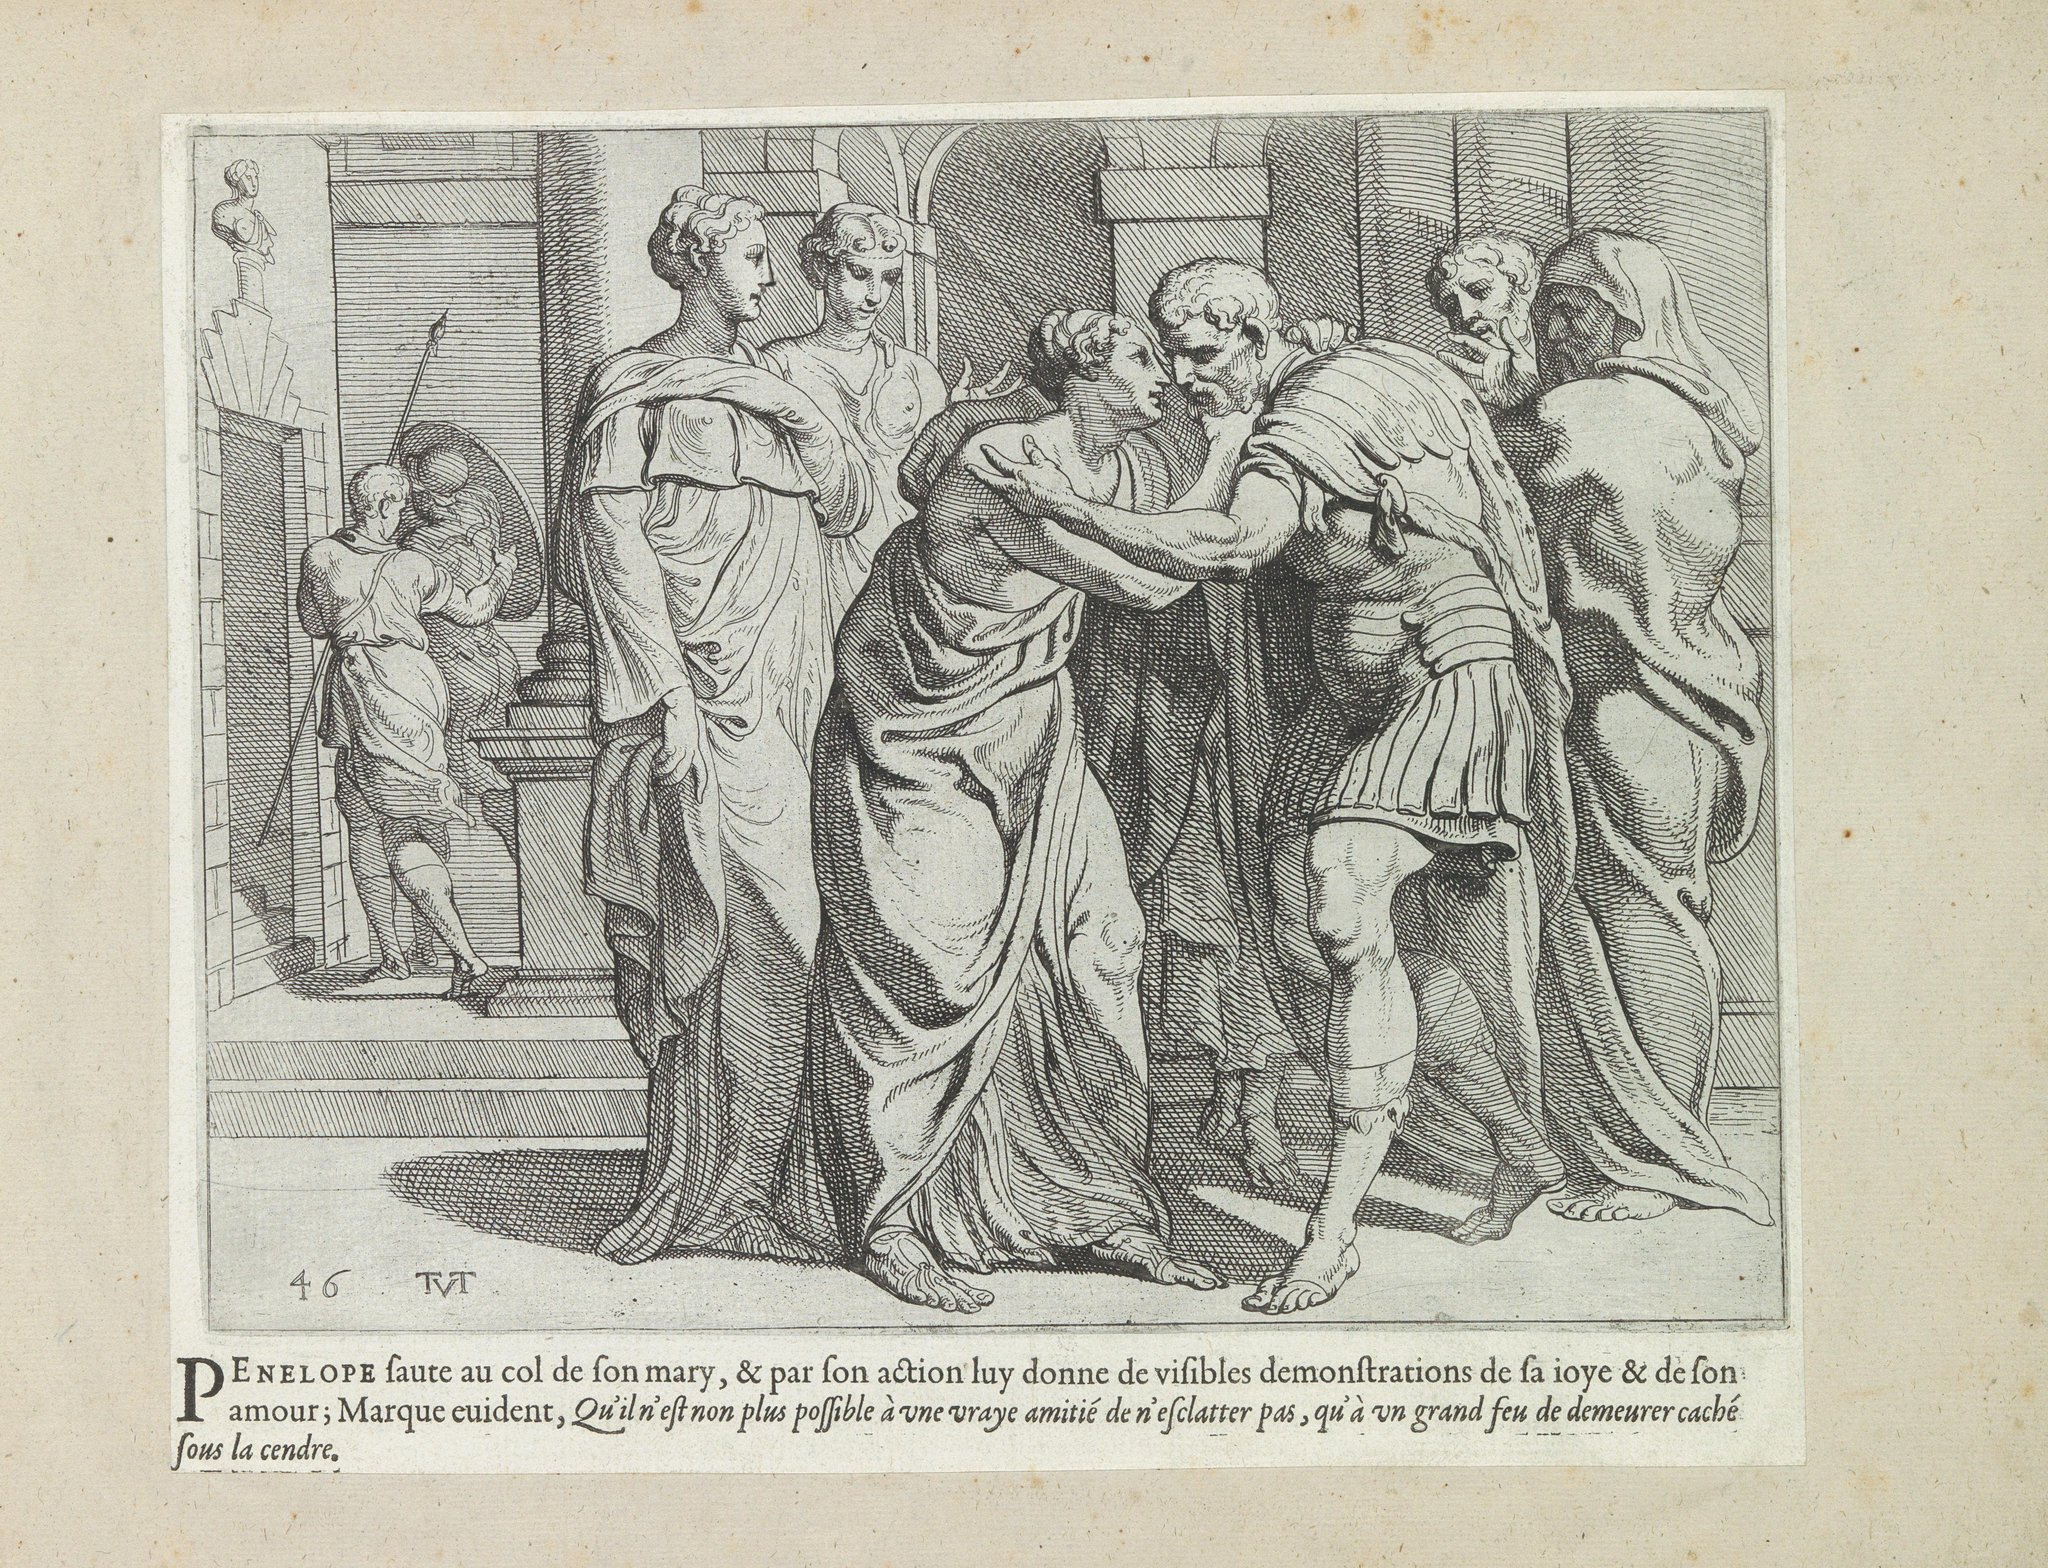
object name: print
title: Les Travaux d'Ulysse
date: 1633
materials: paper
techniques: engraving, etching, letterpress printing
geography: paris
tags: penelope and ulysses embrace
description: Na de lange omzwervingen van Odysseus vallen hij en Penelope elkaar in de armen. De prent maakt deel uit van een album.